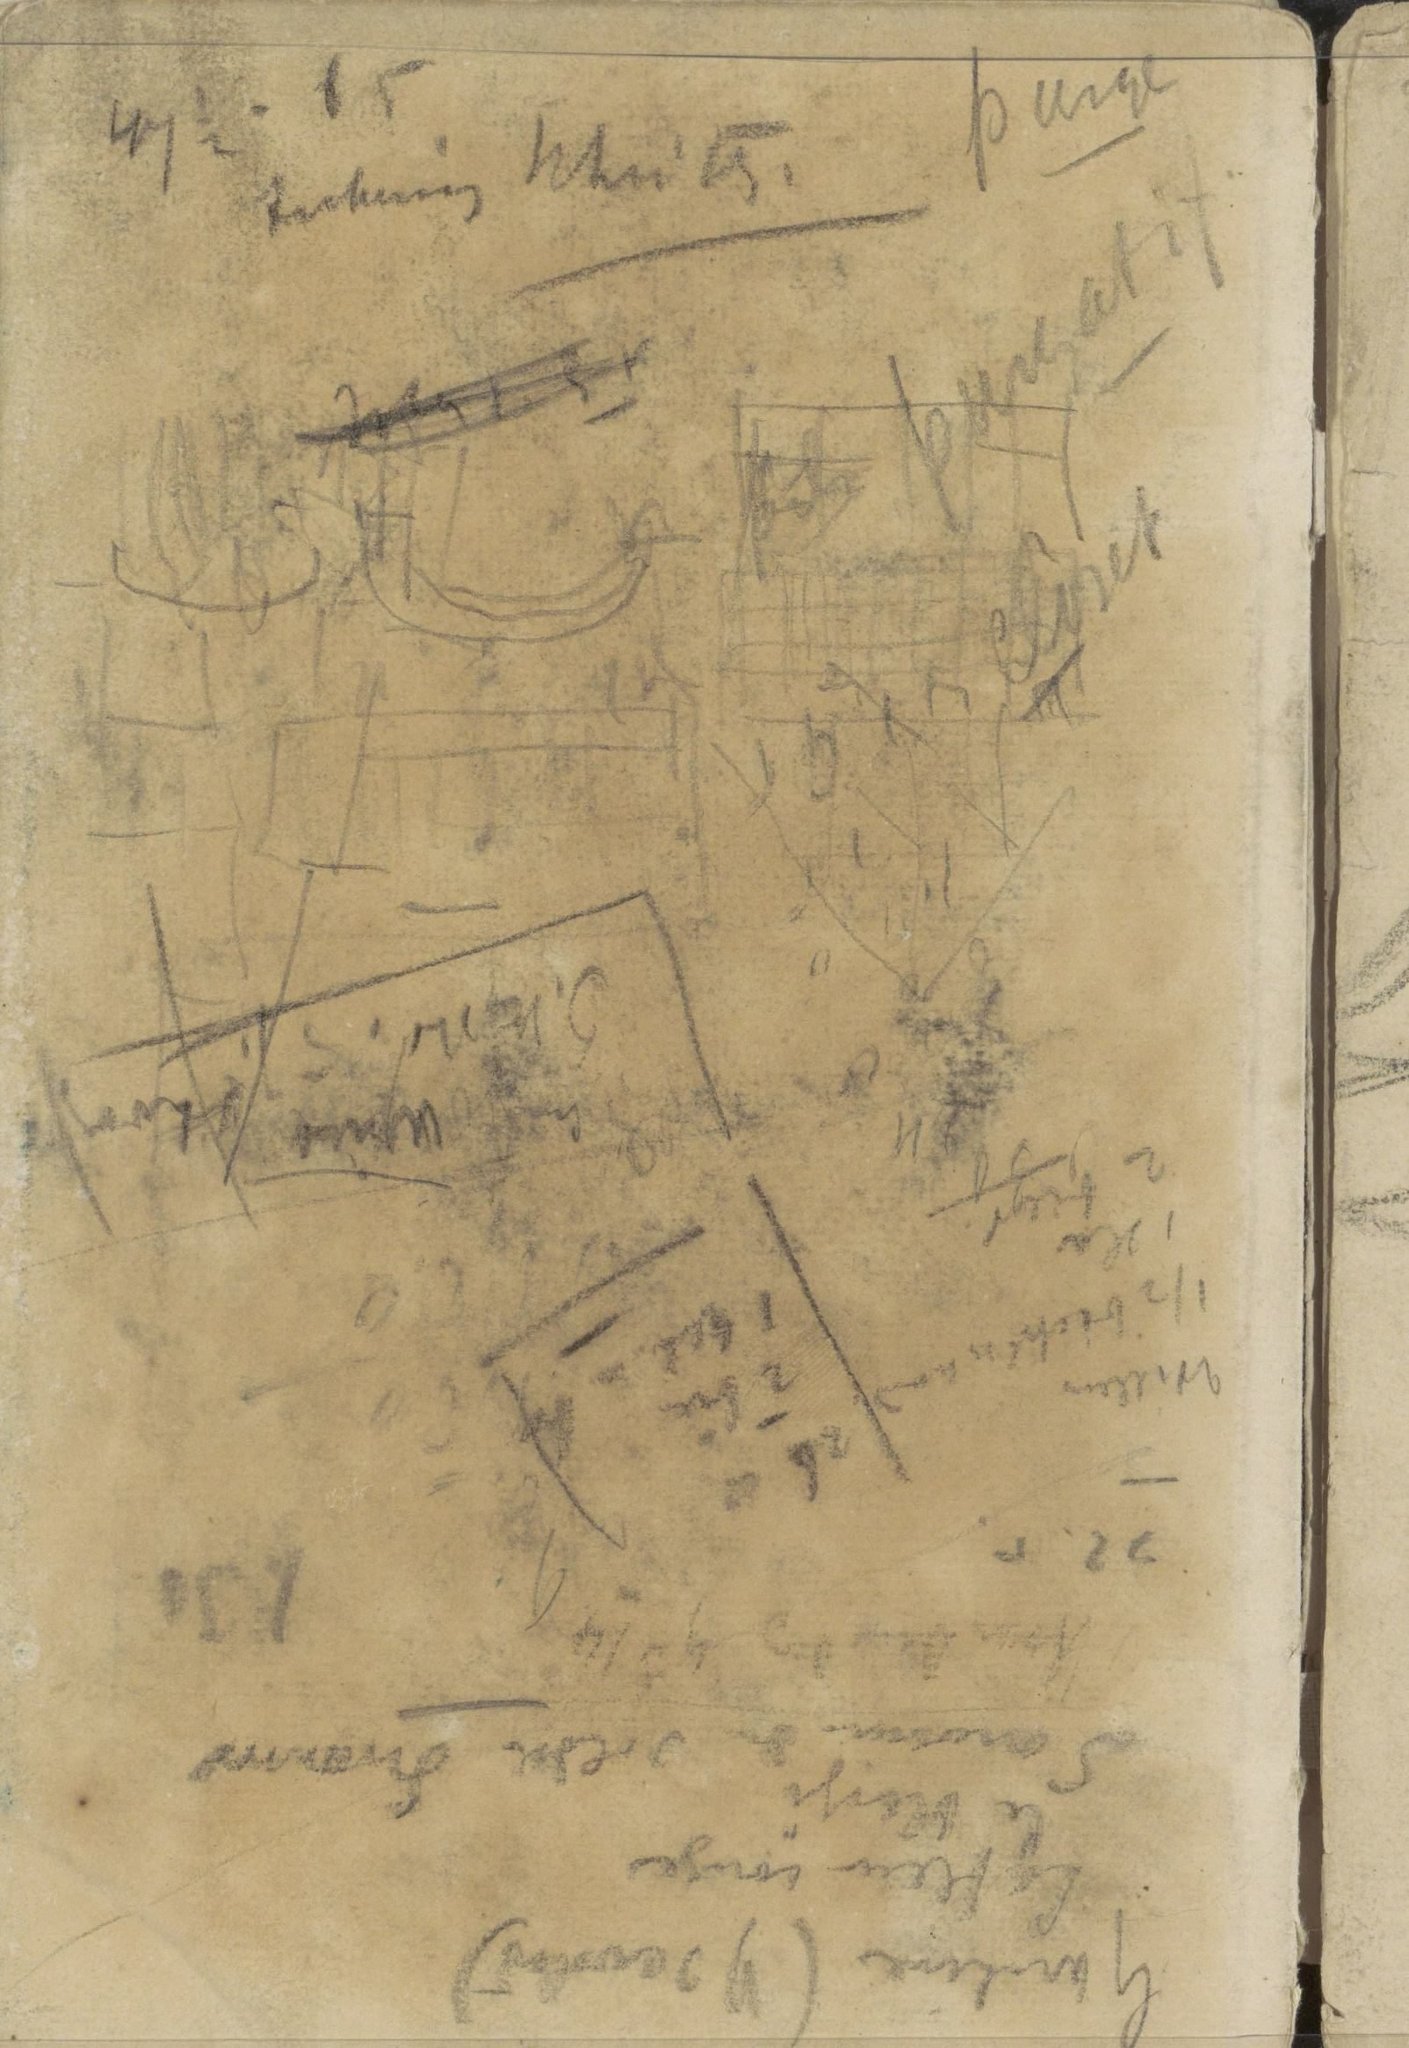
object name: sketchbook leaf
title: Architectuurstudie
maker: george hendrik breitner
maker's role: draughtsman, painter, print maker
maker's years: 1857-1923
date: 1886-1923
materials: paper, pencil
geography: amsterdam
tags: architecture, city-gate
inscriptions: annotation: ‘[...]’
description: Mogelijk een stadspoort. Pagina 55 uit een schetsboek met 19 bladen en 9 losse tekeningen.